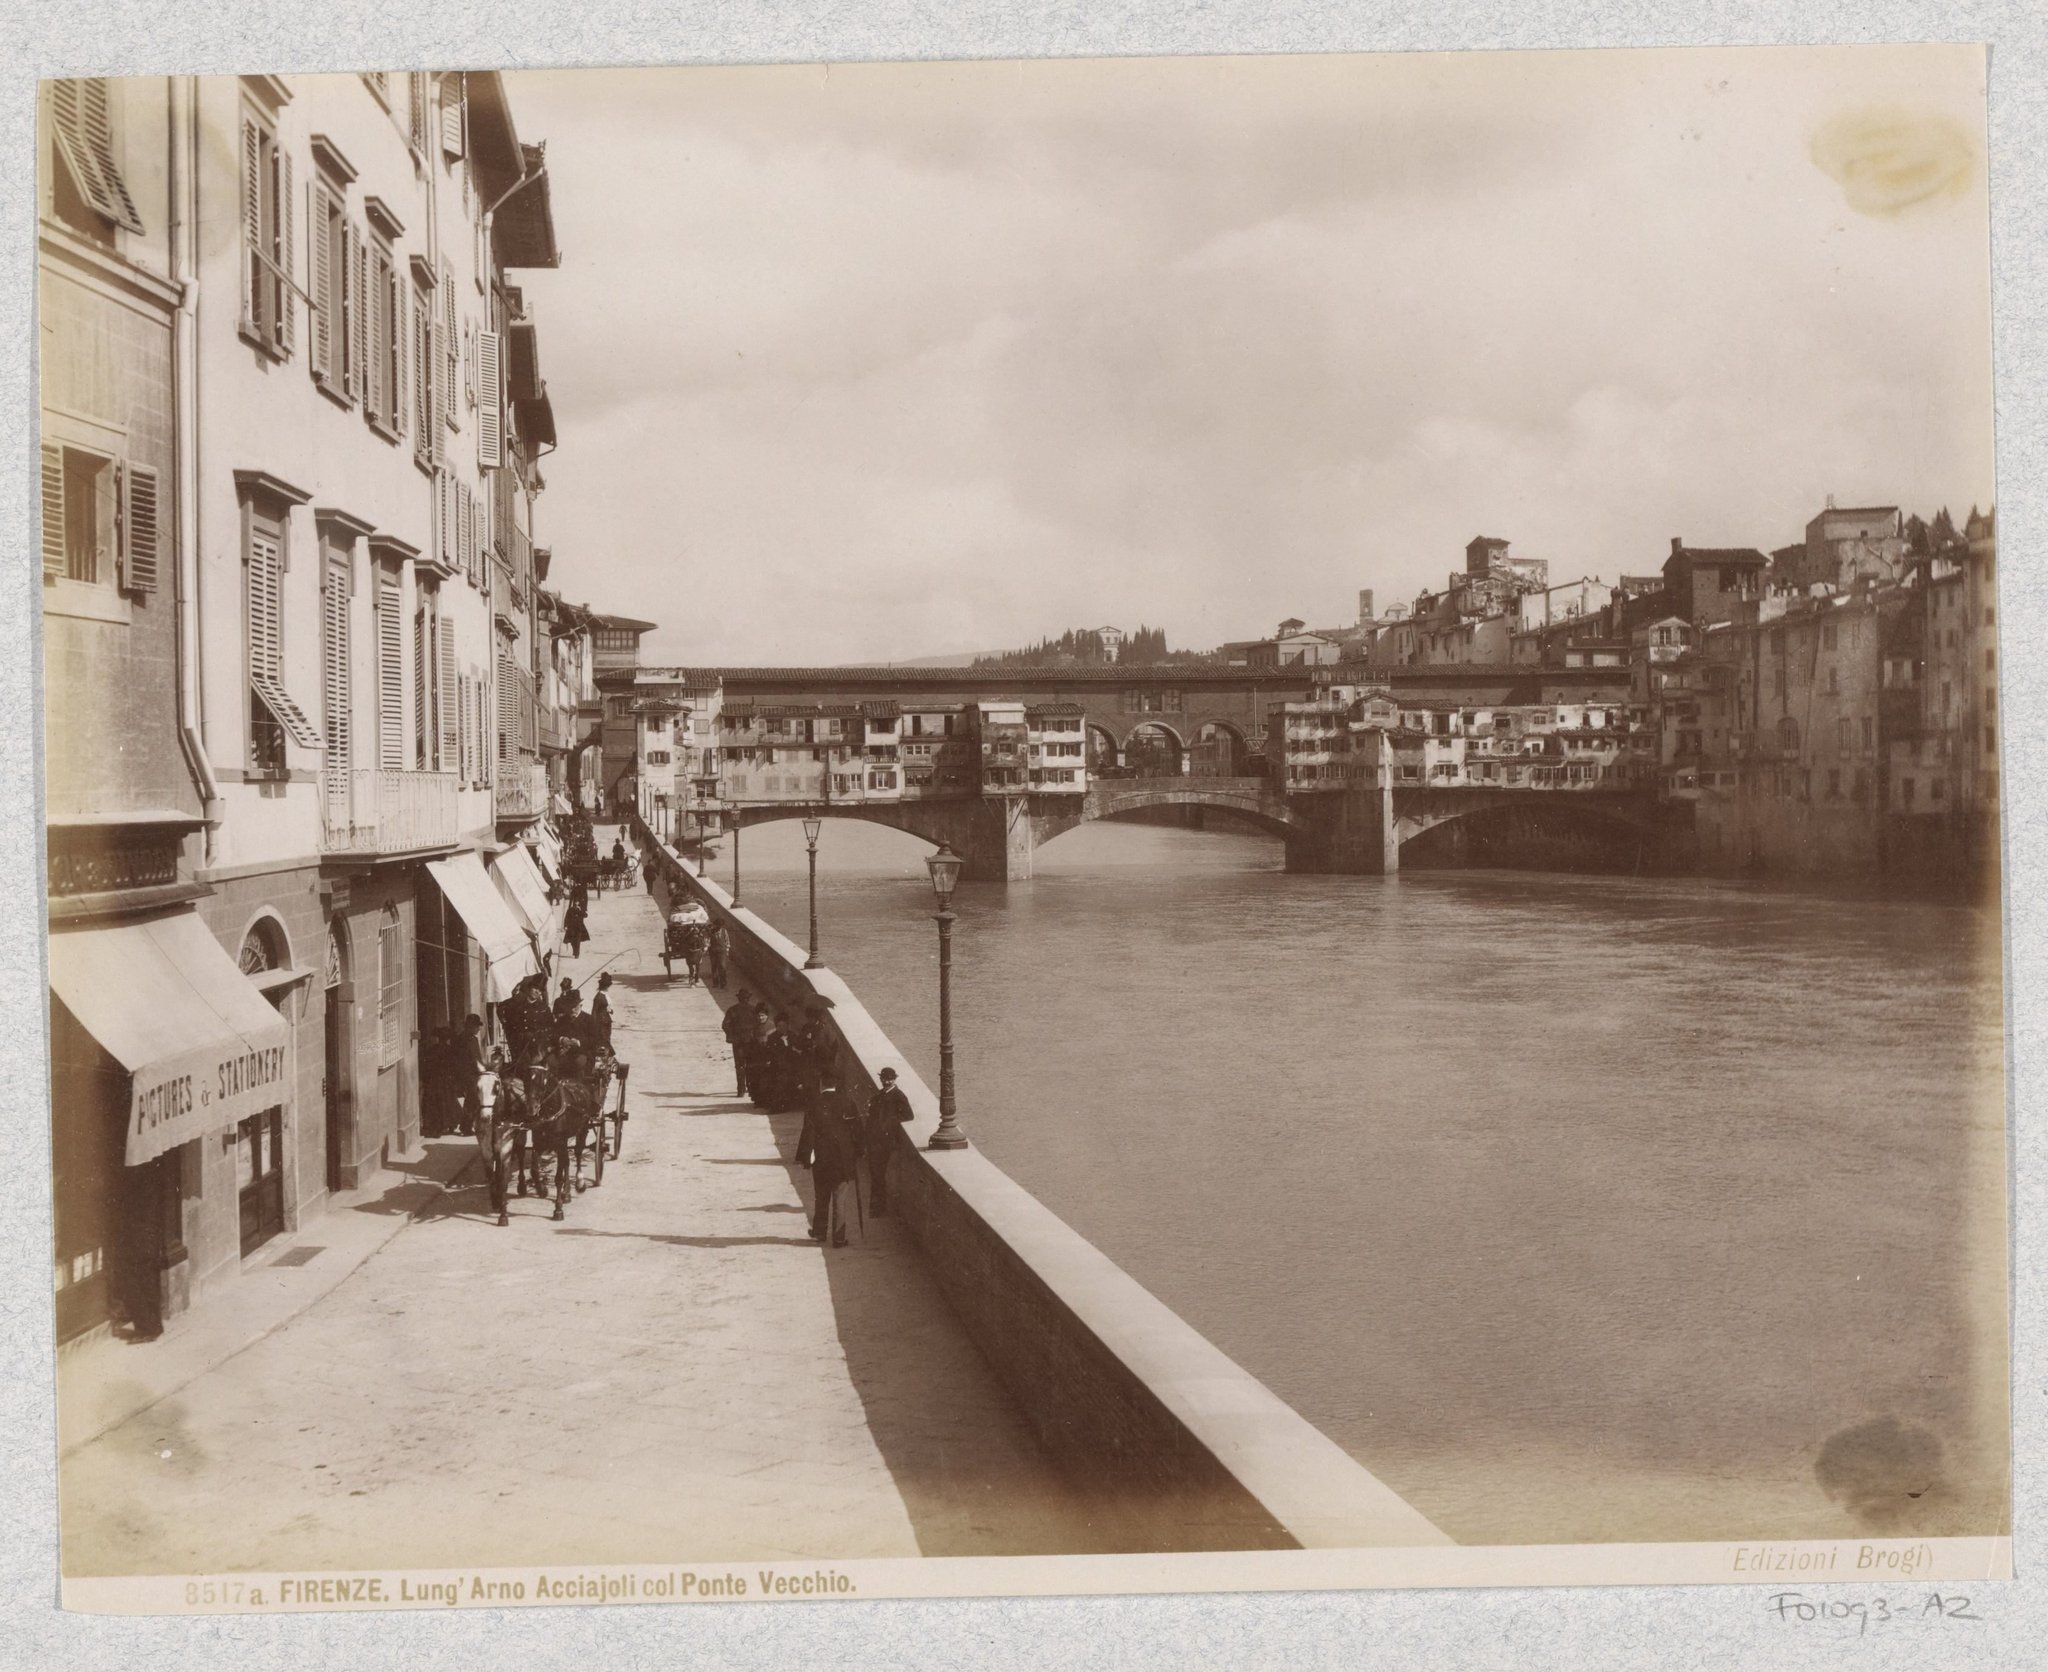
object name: photograph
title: Gezicht op de Ponte Vecchio in Florence met links Lungarno degli Acciaiuoli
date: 1870-1890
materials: paper, photographic support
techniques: albumen print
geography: florence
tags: four-wheeled, animal-drawn vehicle, e.g.: cab, carriage, coach, bridge in city with structures, i.e. shops, houses, e.g. ponte vecchio in florence, bridge, quay (+ city(-scape) with figures, staffage), prospect of city, town panorama, silhouette of city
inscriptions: negative number: ‘8517a’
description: Onderdeel van Reisalbum met foto's van bezienswaardigheden in Genua, Florence en Venetië.